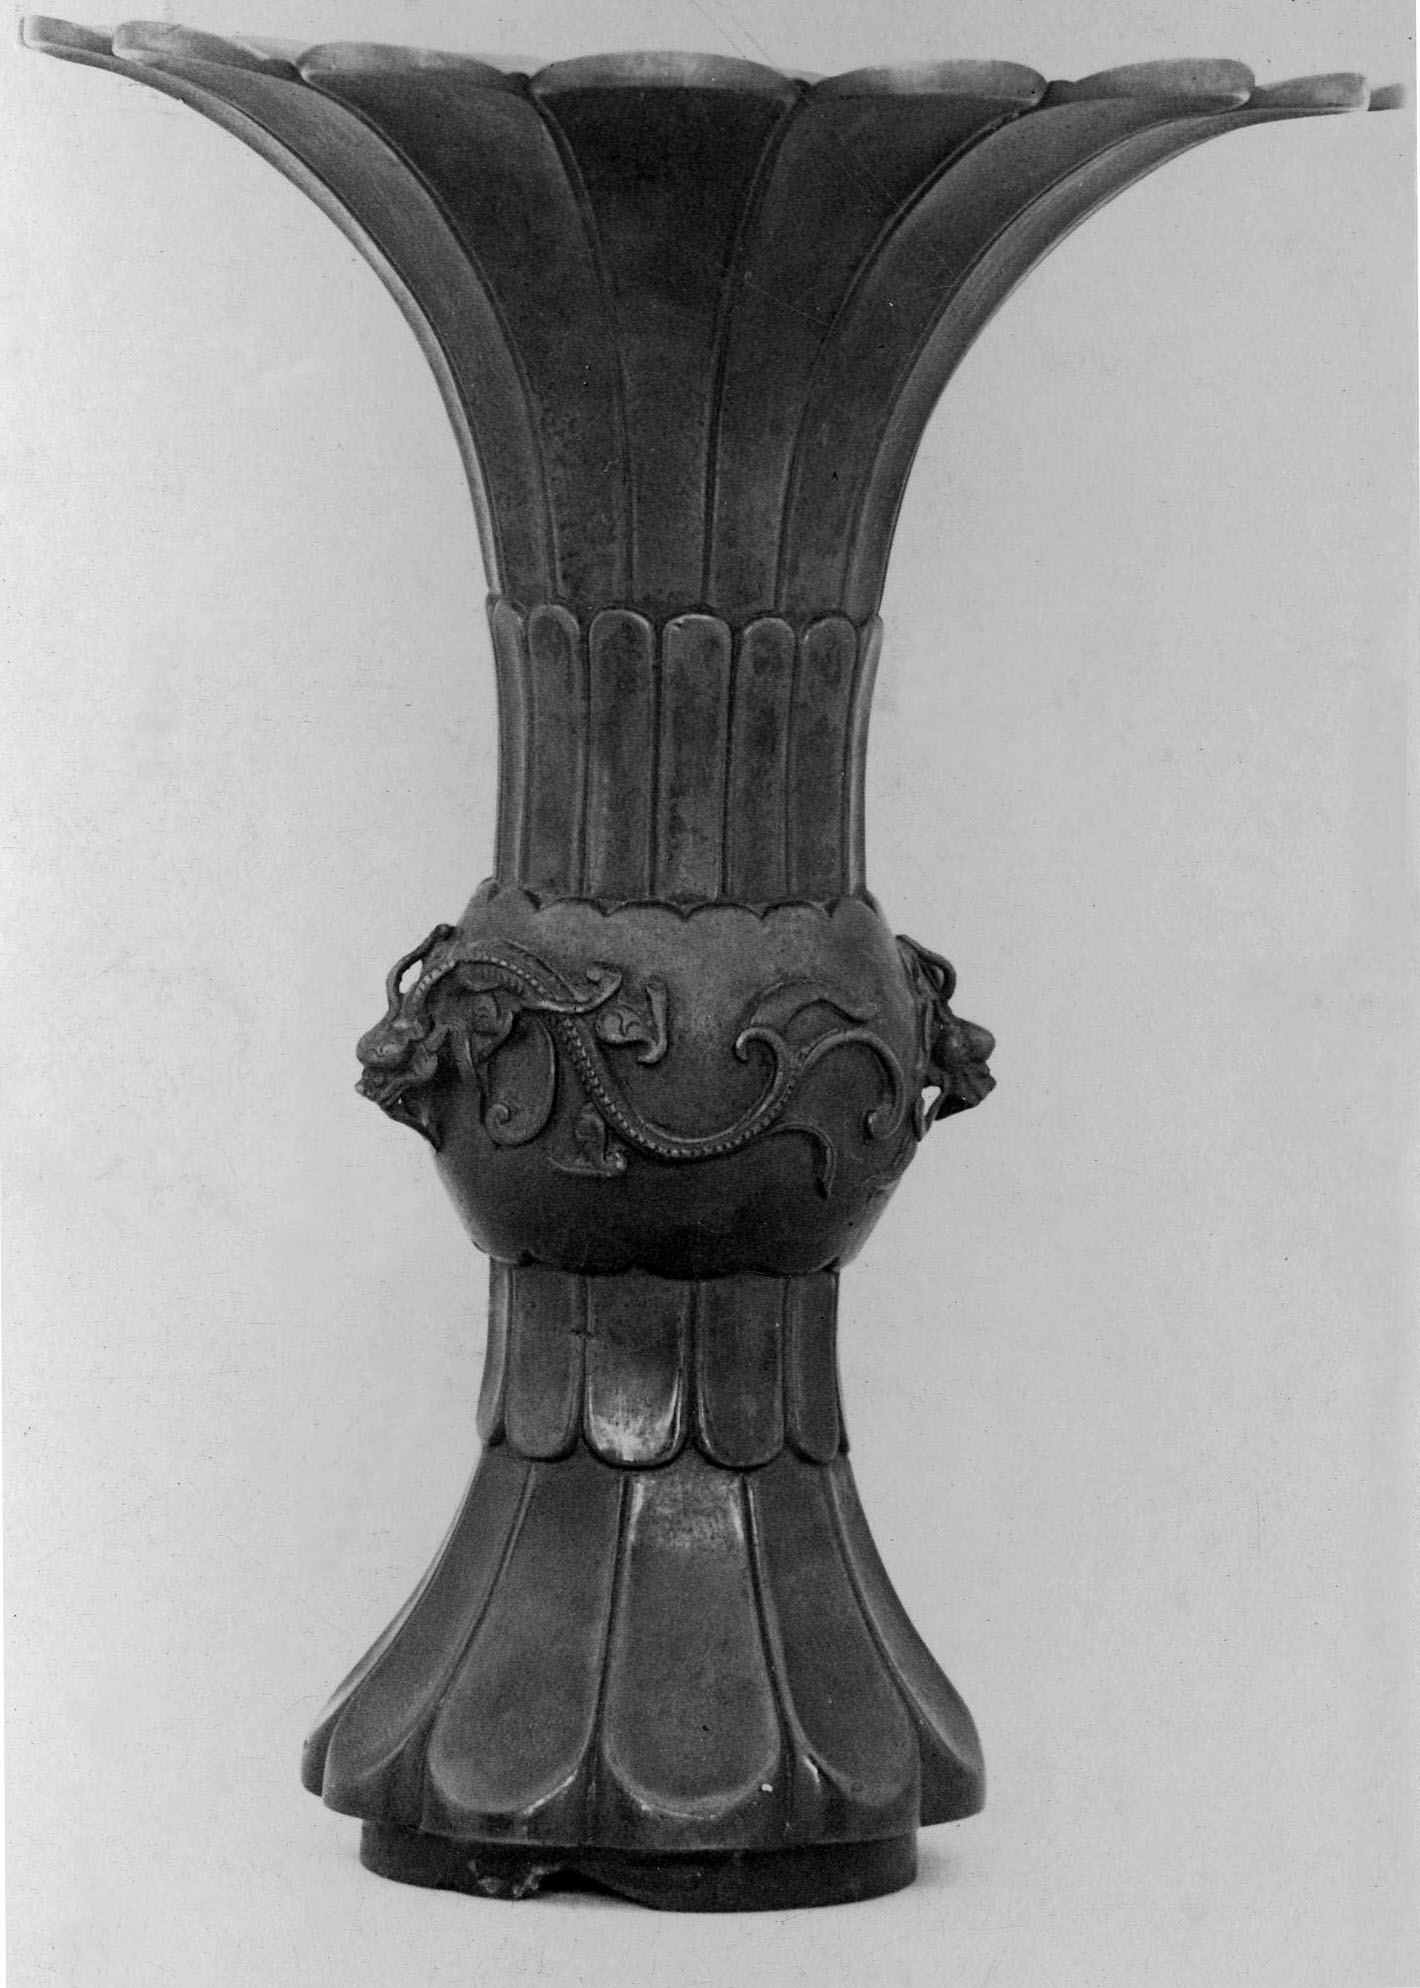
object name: vase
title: Vase with Foliated Rim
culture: chinese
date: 1601-1700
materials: bronze